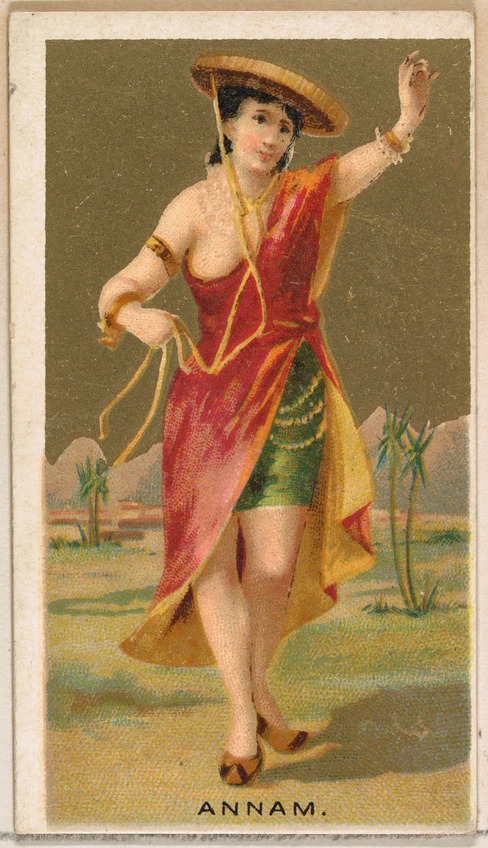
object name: print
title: Annam, from the Dancing Girls of the World series (N185) issued by Wm. S. Kimball & Co.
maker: william s. kimball & company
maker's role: publisher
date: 1889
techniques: color lithograph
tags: women,dancers